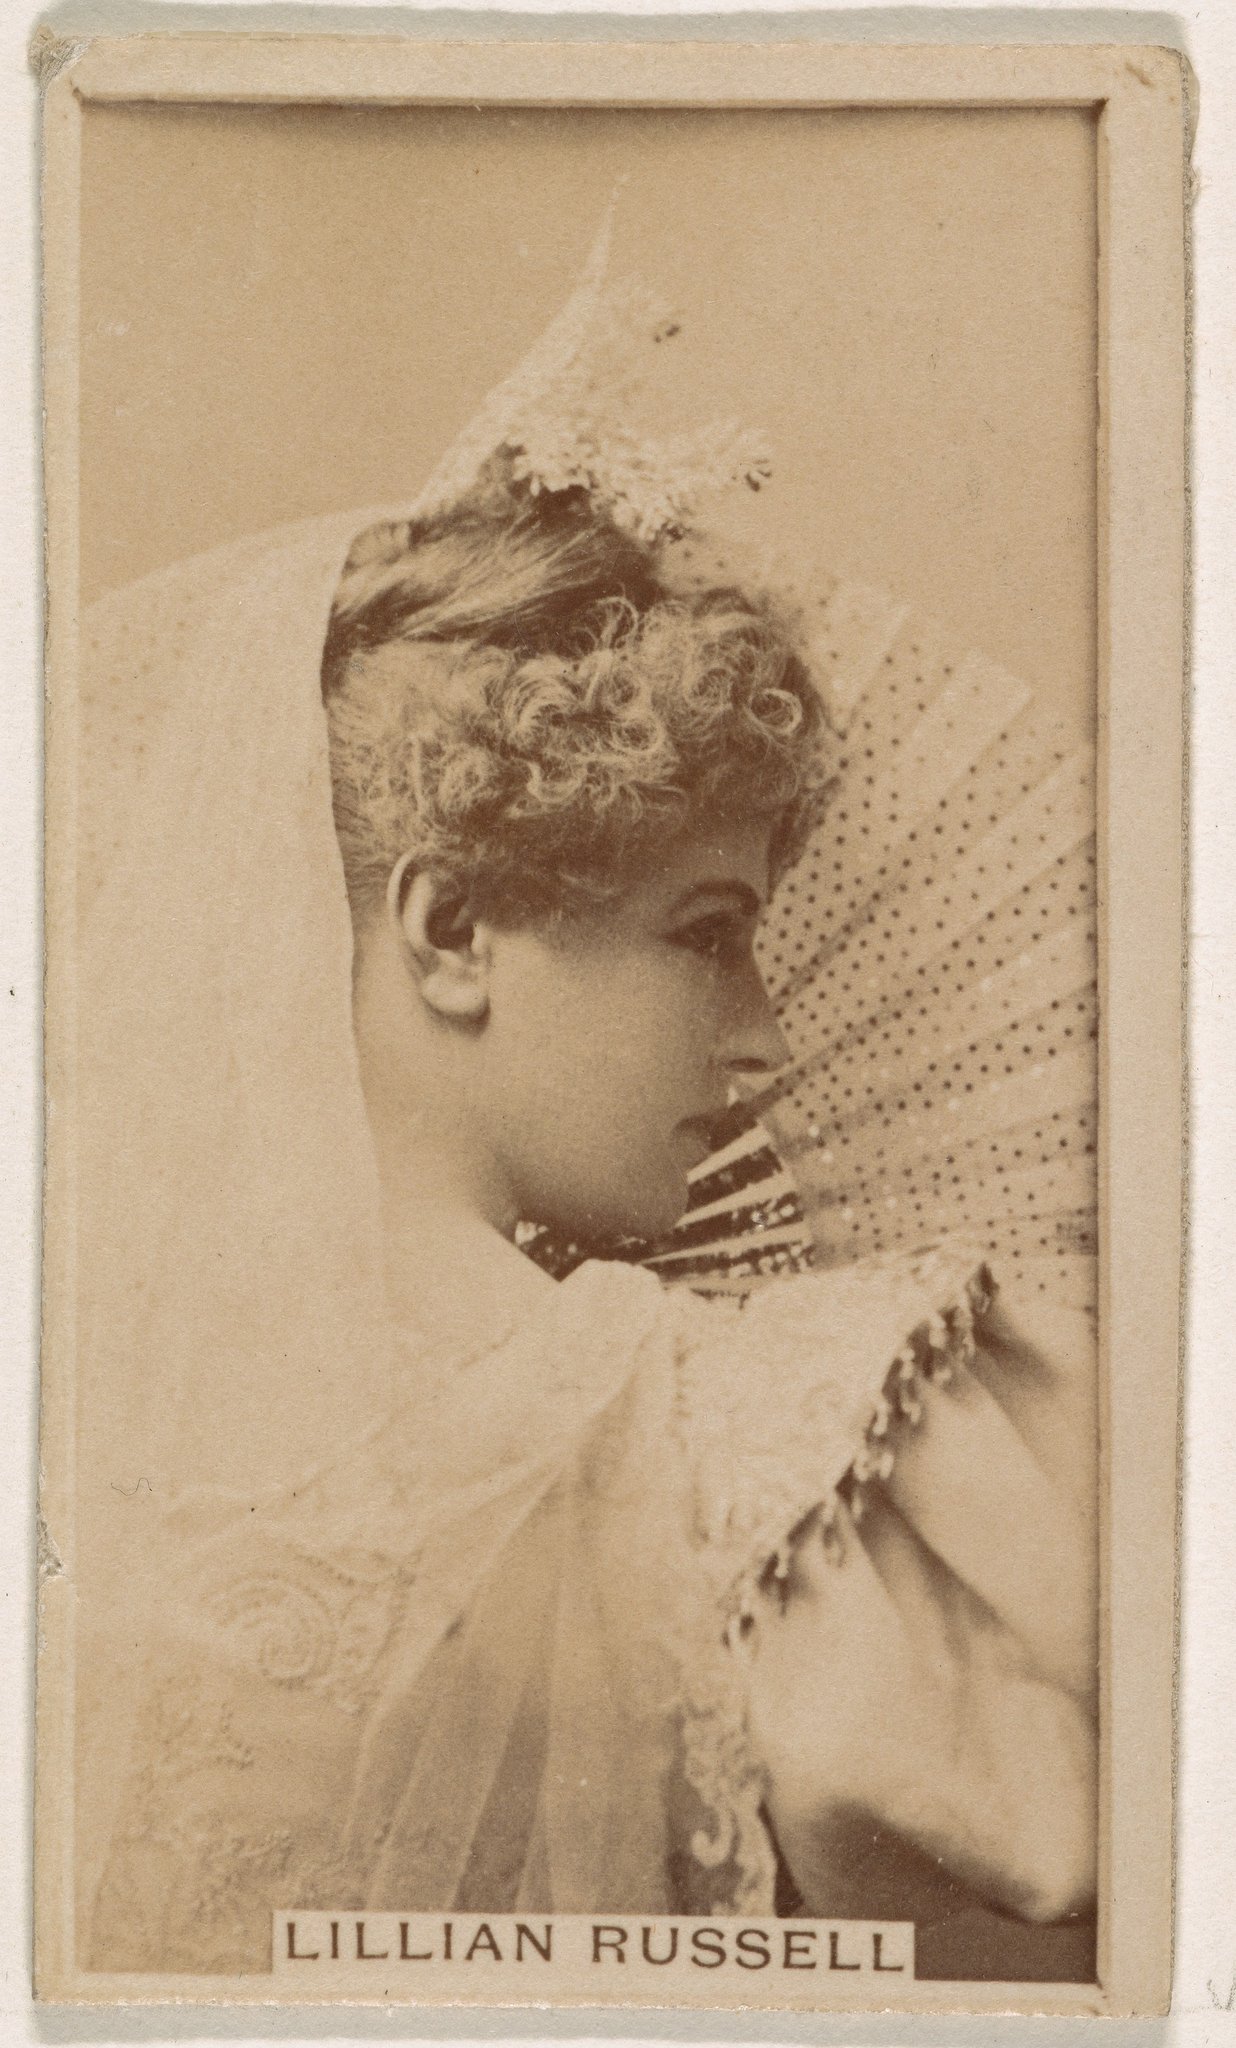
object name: photograph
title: Lillian Russell, from the Actresses series (N245) issued by Kinney Brothers to promote Sweet Caporal Cigarettes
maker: kinney brothers tobacco company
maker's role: publisher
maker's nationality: american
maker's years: 1869-2011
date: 1890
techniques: albumen silver print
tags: women,actresses